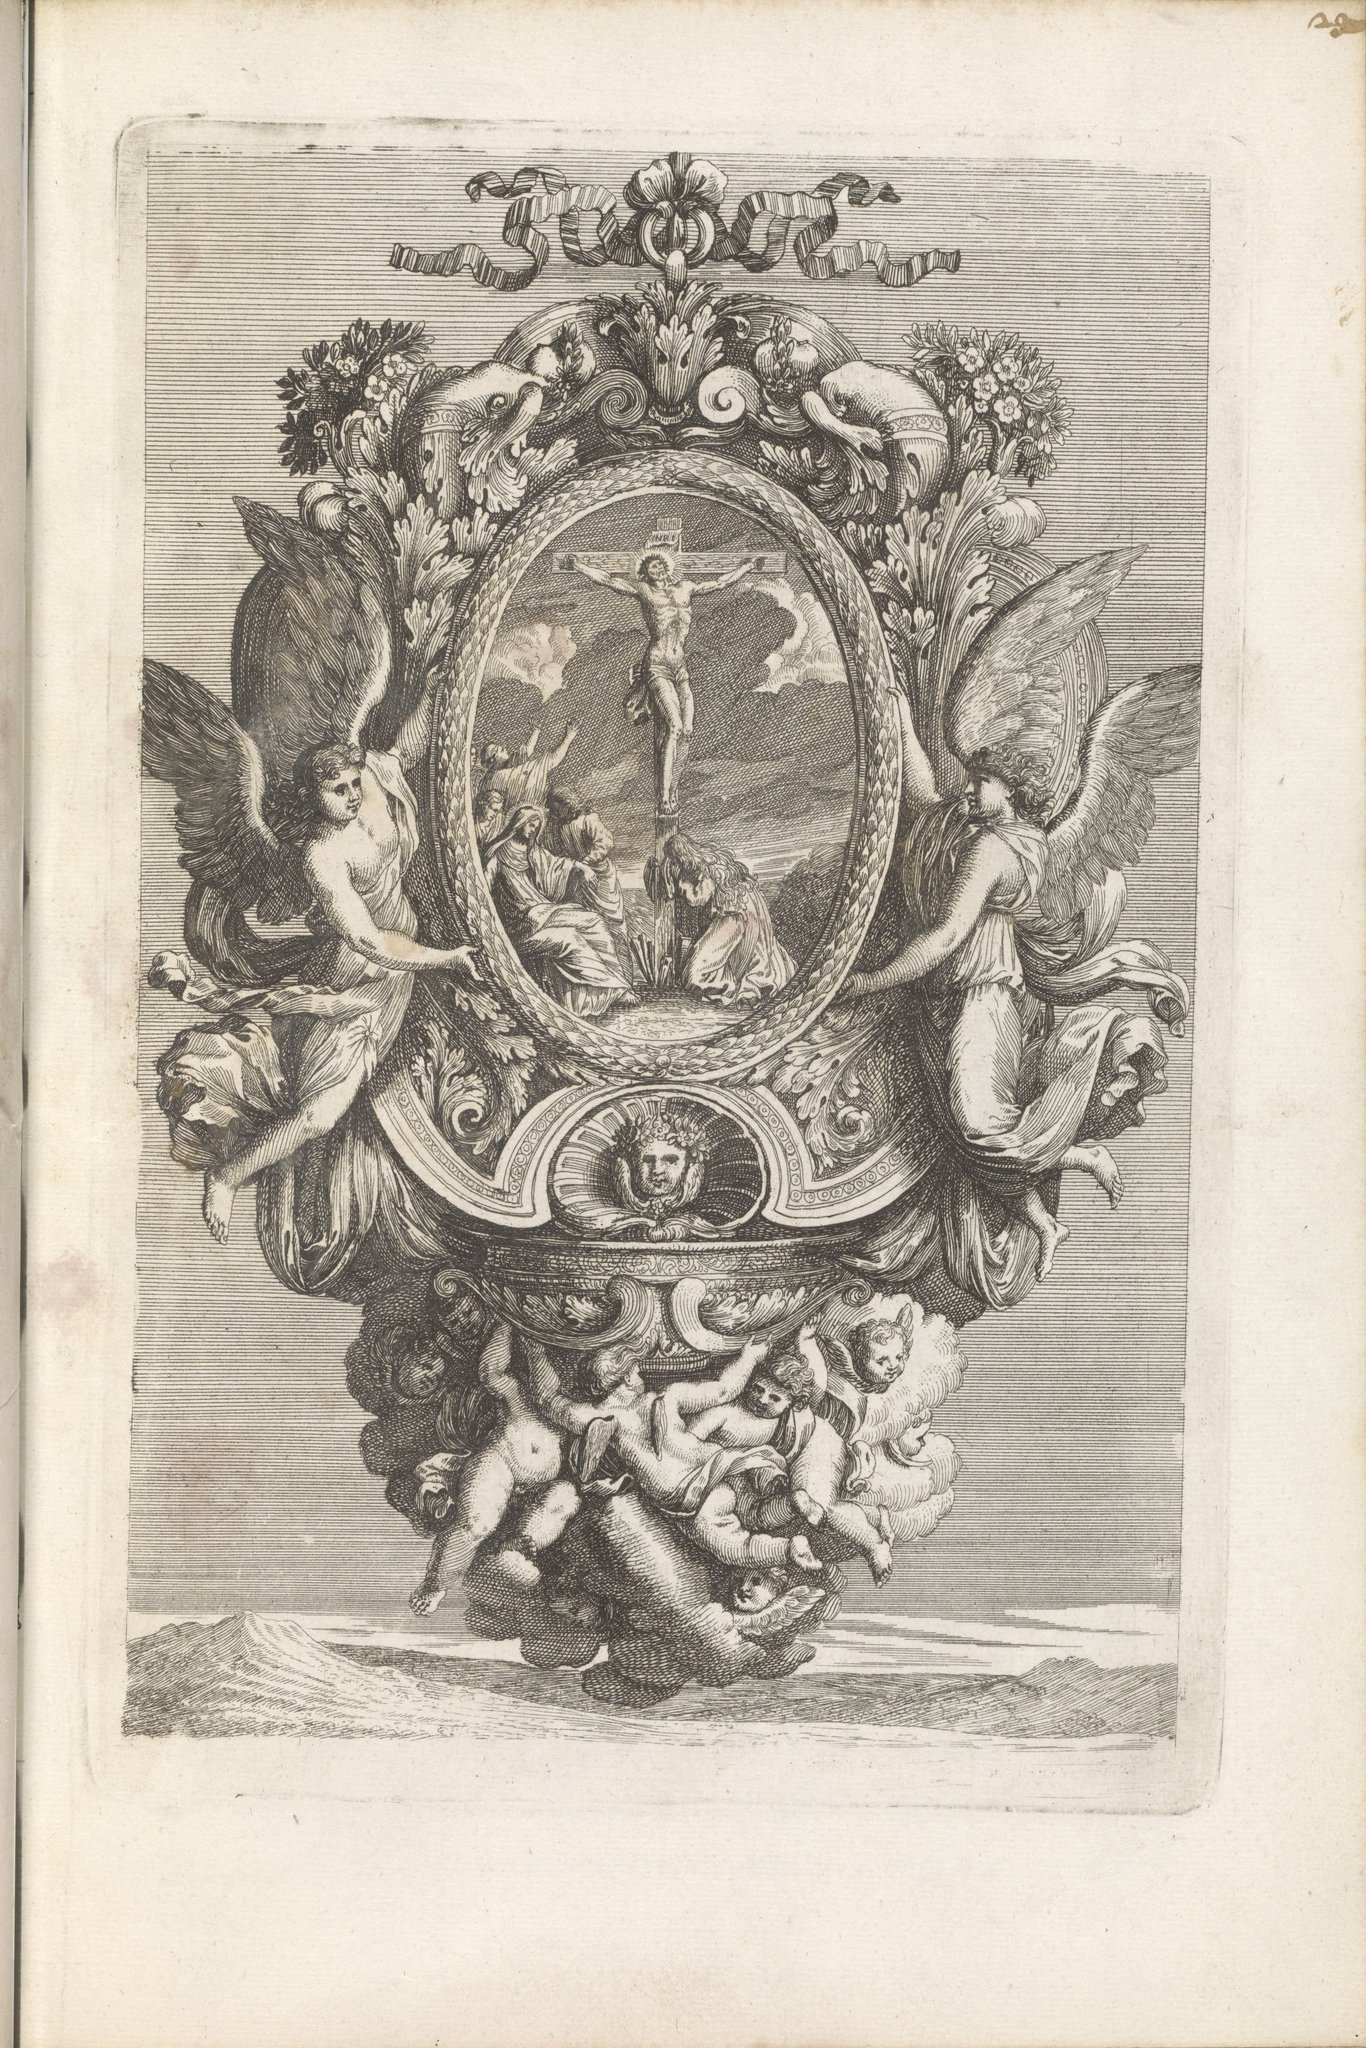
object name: album leaf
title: Wijwaterbak met de Kruisiging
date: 1677-1692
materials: paper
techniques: etching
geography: paris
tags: ornaments ~ art, holy water font, the crucifixion of christ: christ's death on the cross; golgotha (matthew 27:45-58; mark 15:33-45; luke 23:44-52; john 19:25-38)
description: De wijwaterbak wordt ondersteund door drie putti en zes cherubijnen. De achterplaat wordt gevormd door een ovaal medaillon, vastgehouden door twee engelen, met Christus aan het kruis. Uit serie van 6 bladen met kopieën naar de serie Inuentions pour faire des plaques ou des Aubenistiers seruans aux Orfeures van Jean Lepautre. Ontwerpen voor wijwaterbakken. Prent maakt deel uit van een album.